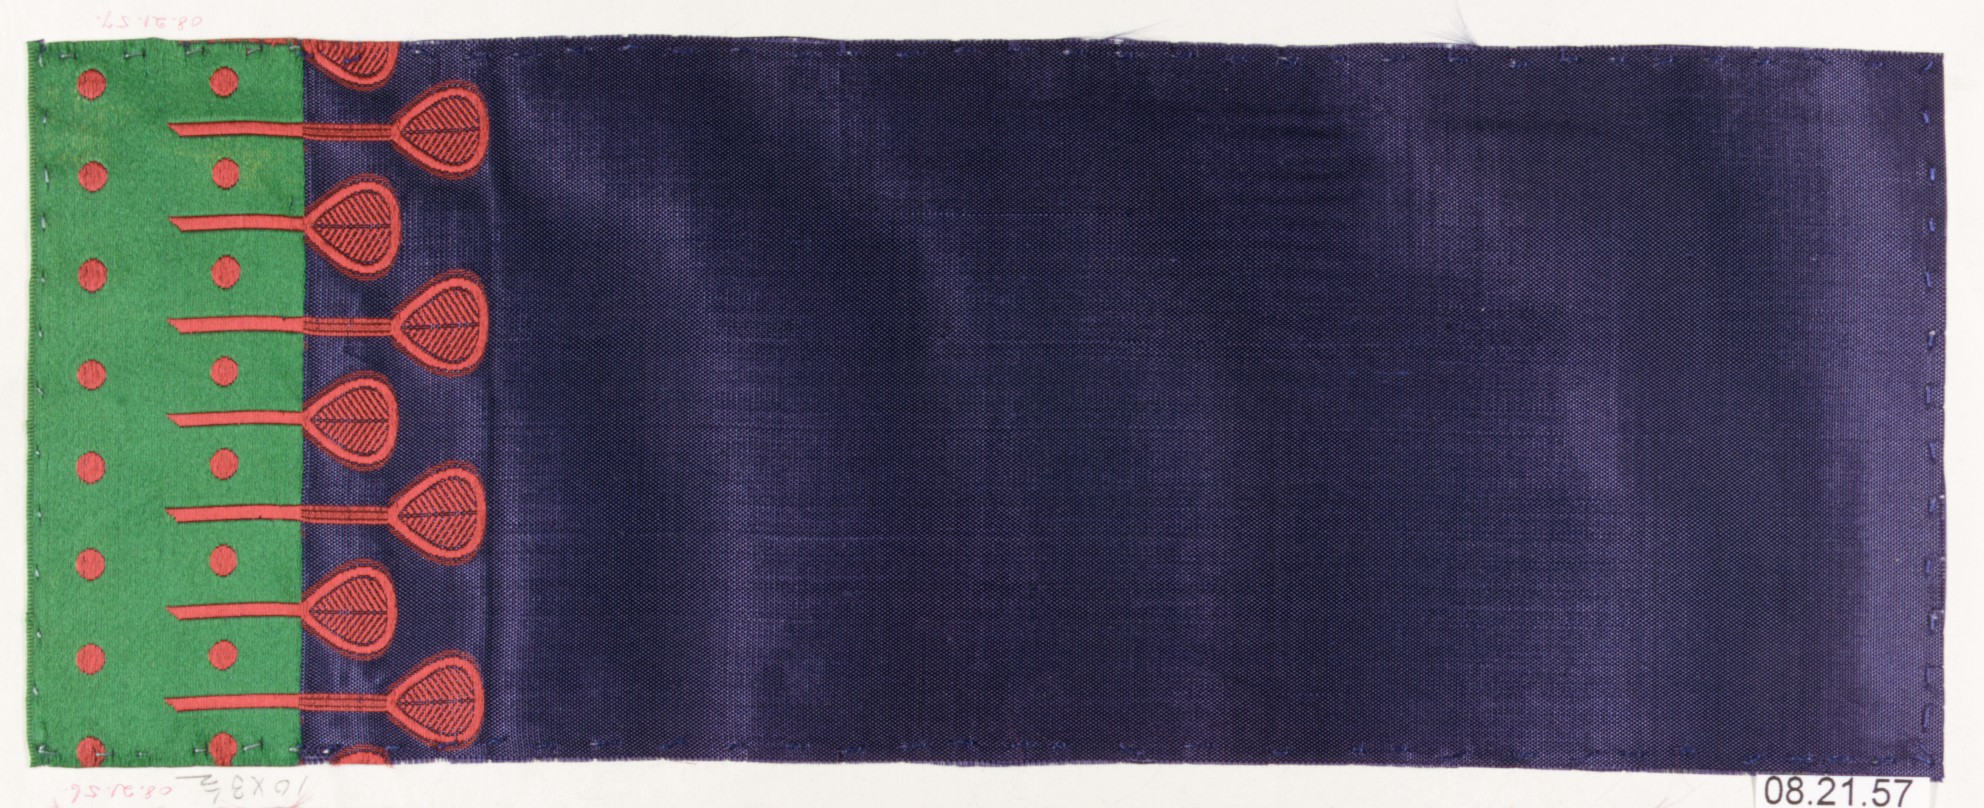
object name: textile sample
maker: Anonymous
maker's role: designer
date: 1900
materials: silk